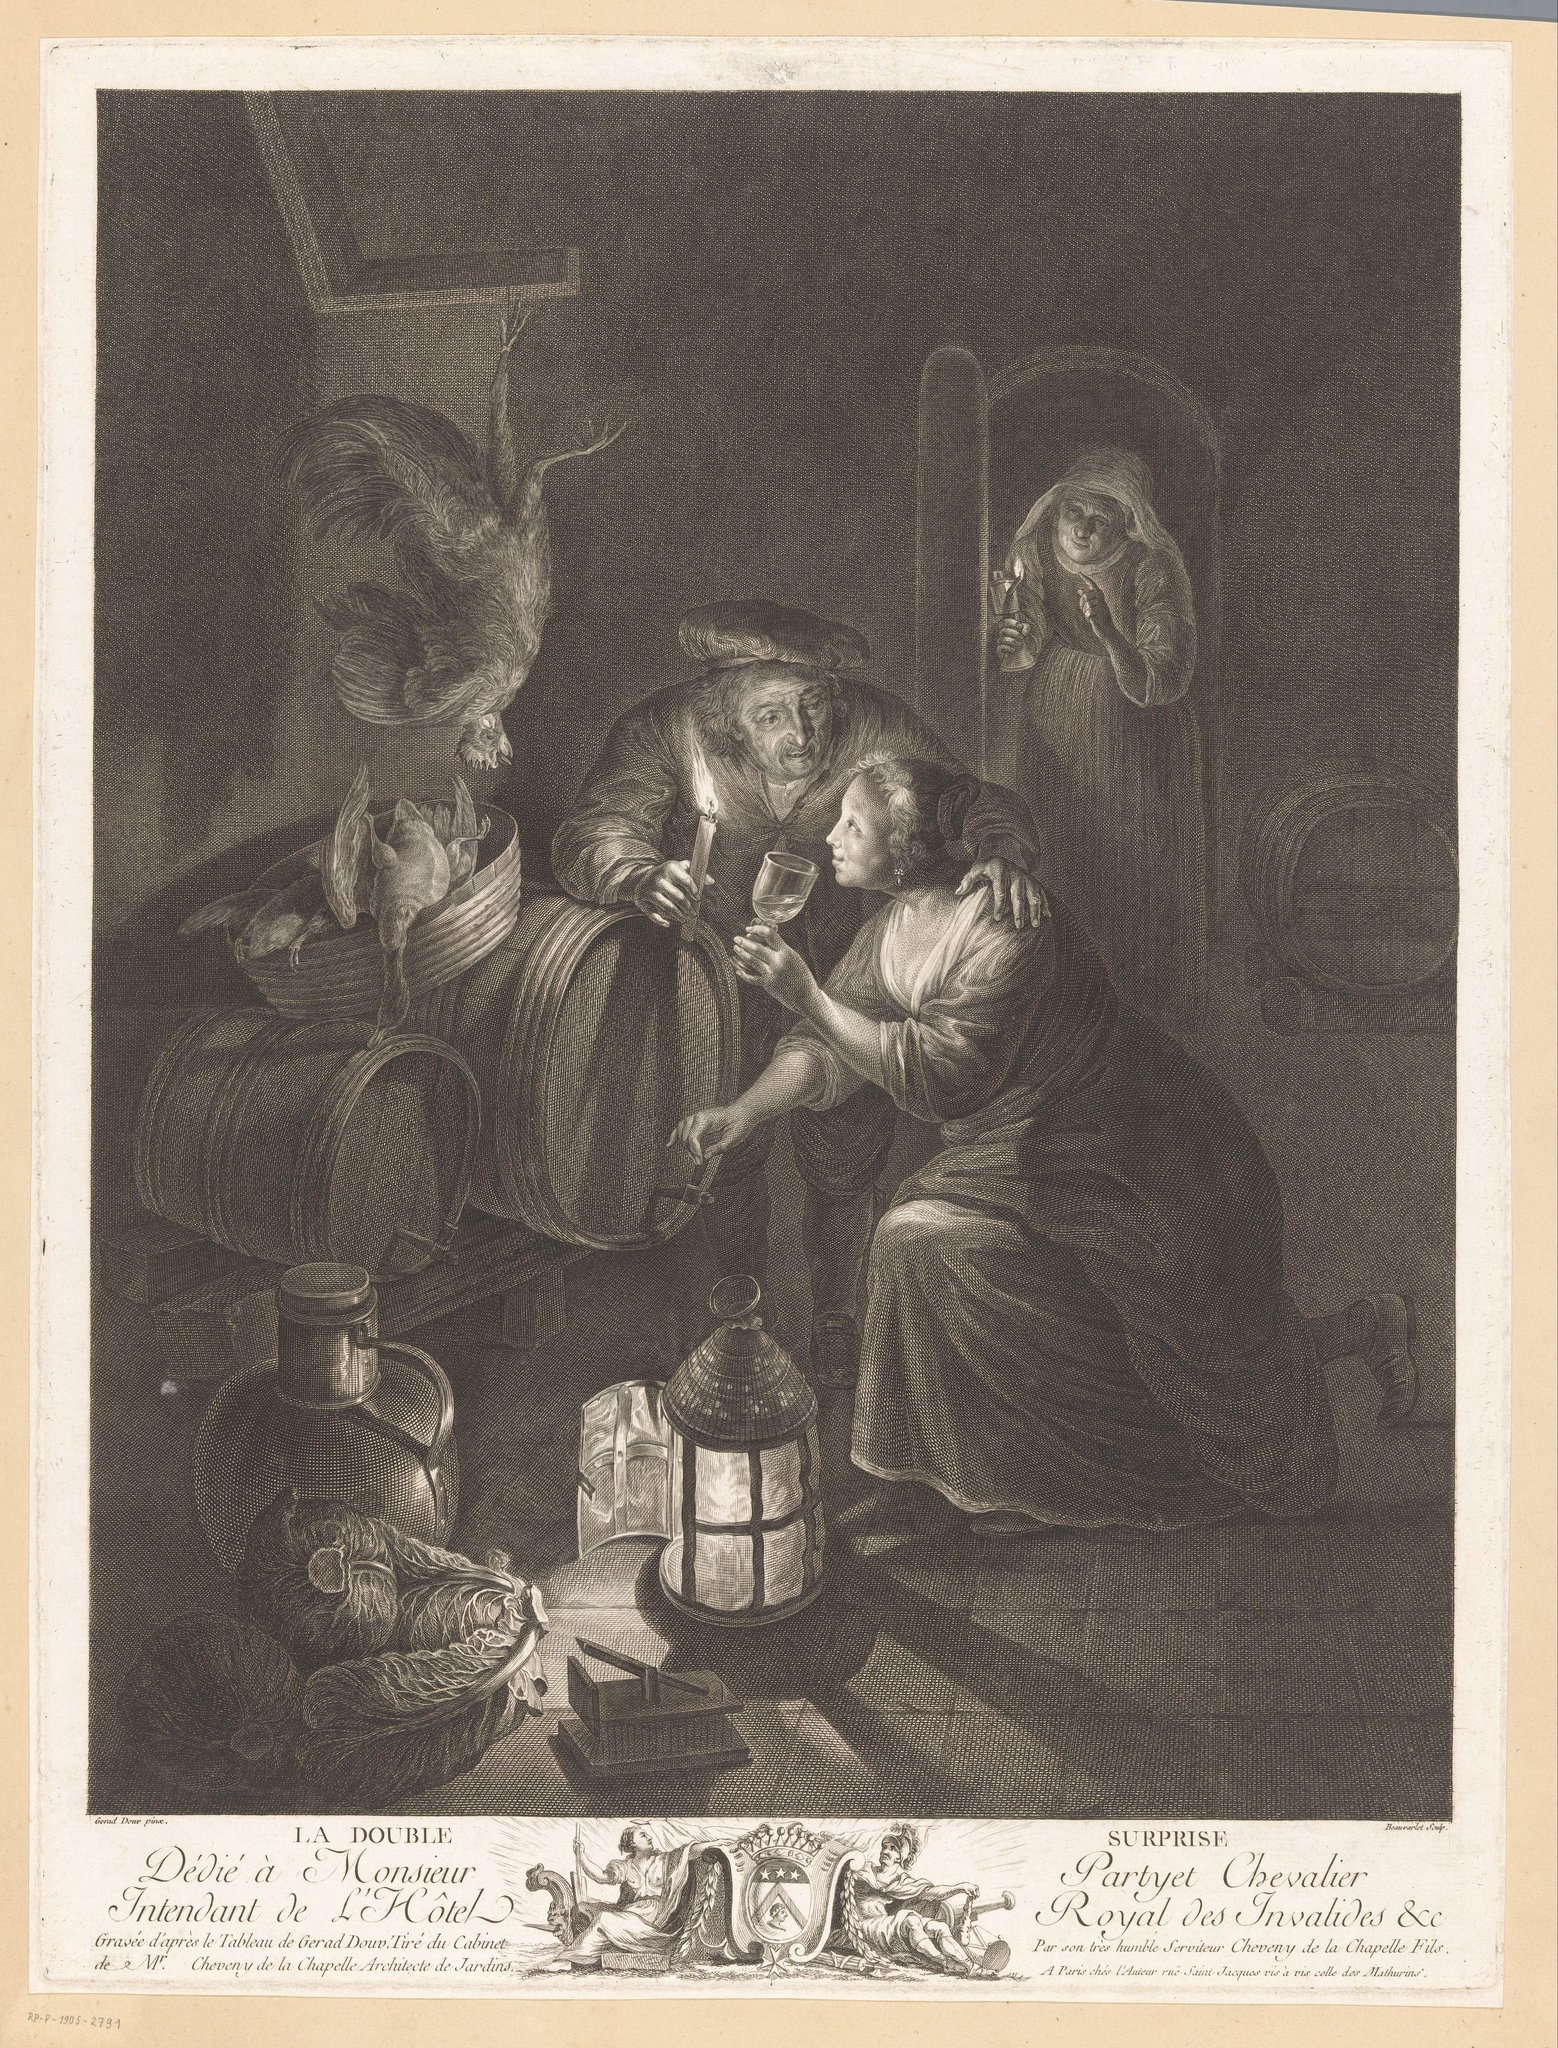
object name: print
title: La double surprise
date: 1741-1797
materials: paper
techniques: engraving, etching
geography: paris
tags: wooden container: barrel, cask, bucket, candle, interrupted meeting, lovers caught by surprise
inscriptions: collector's mark: Lugt 2228